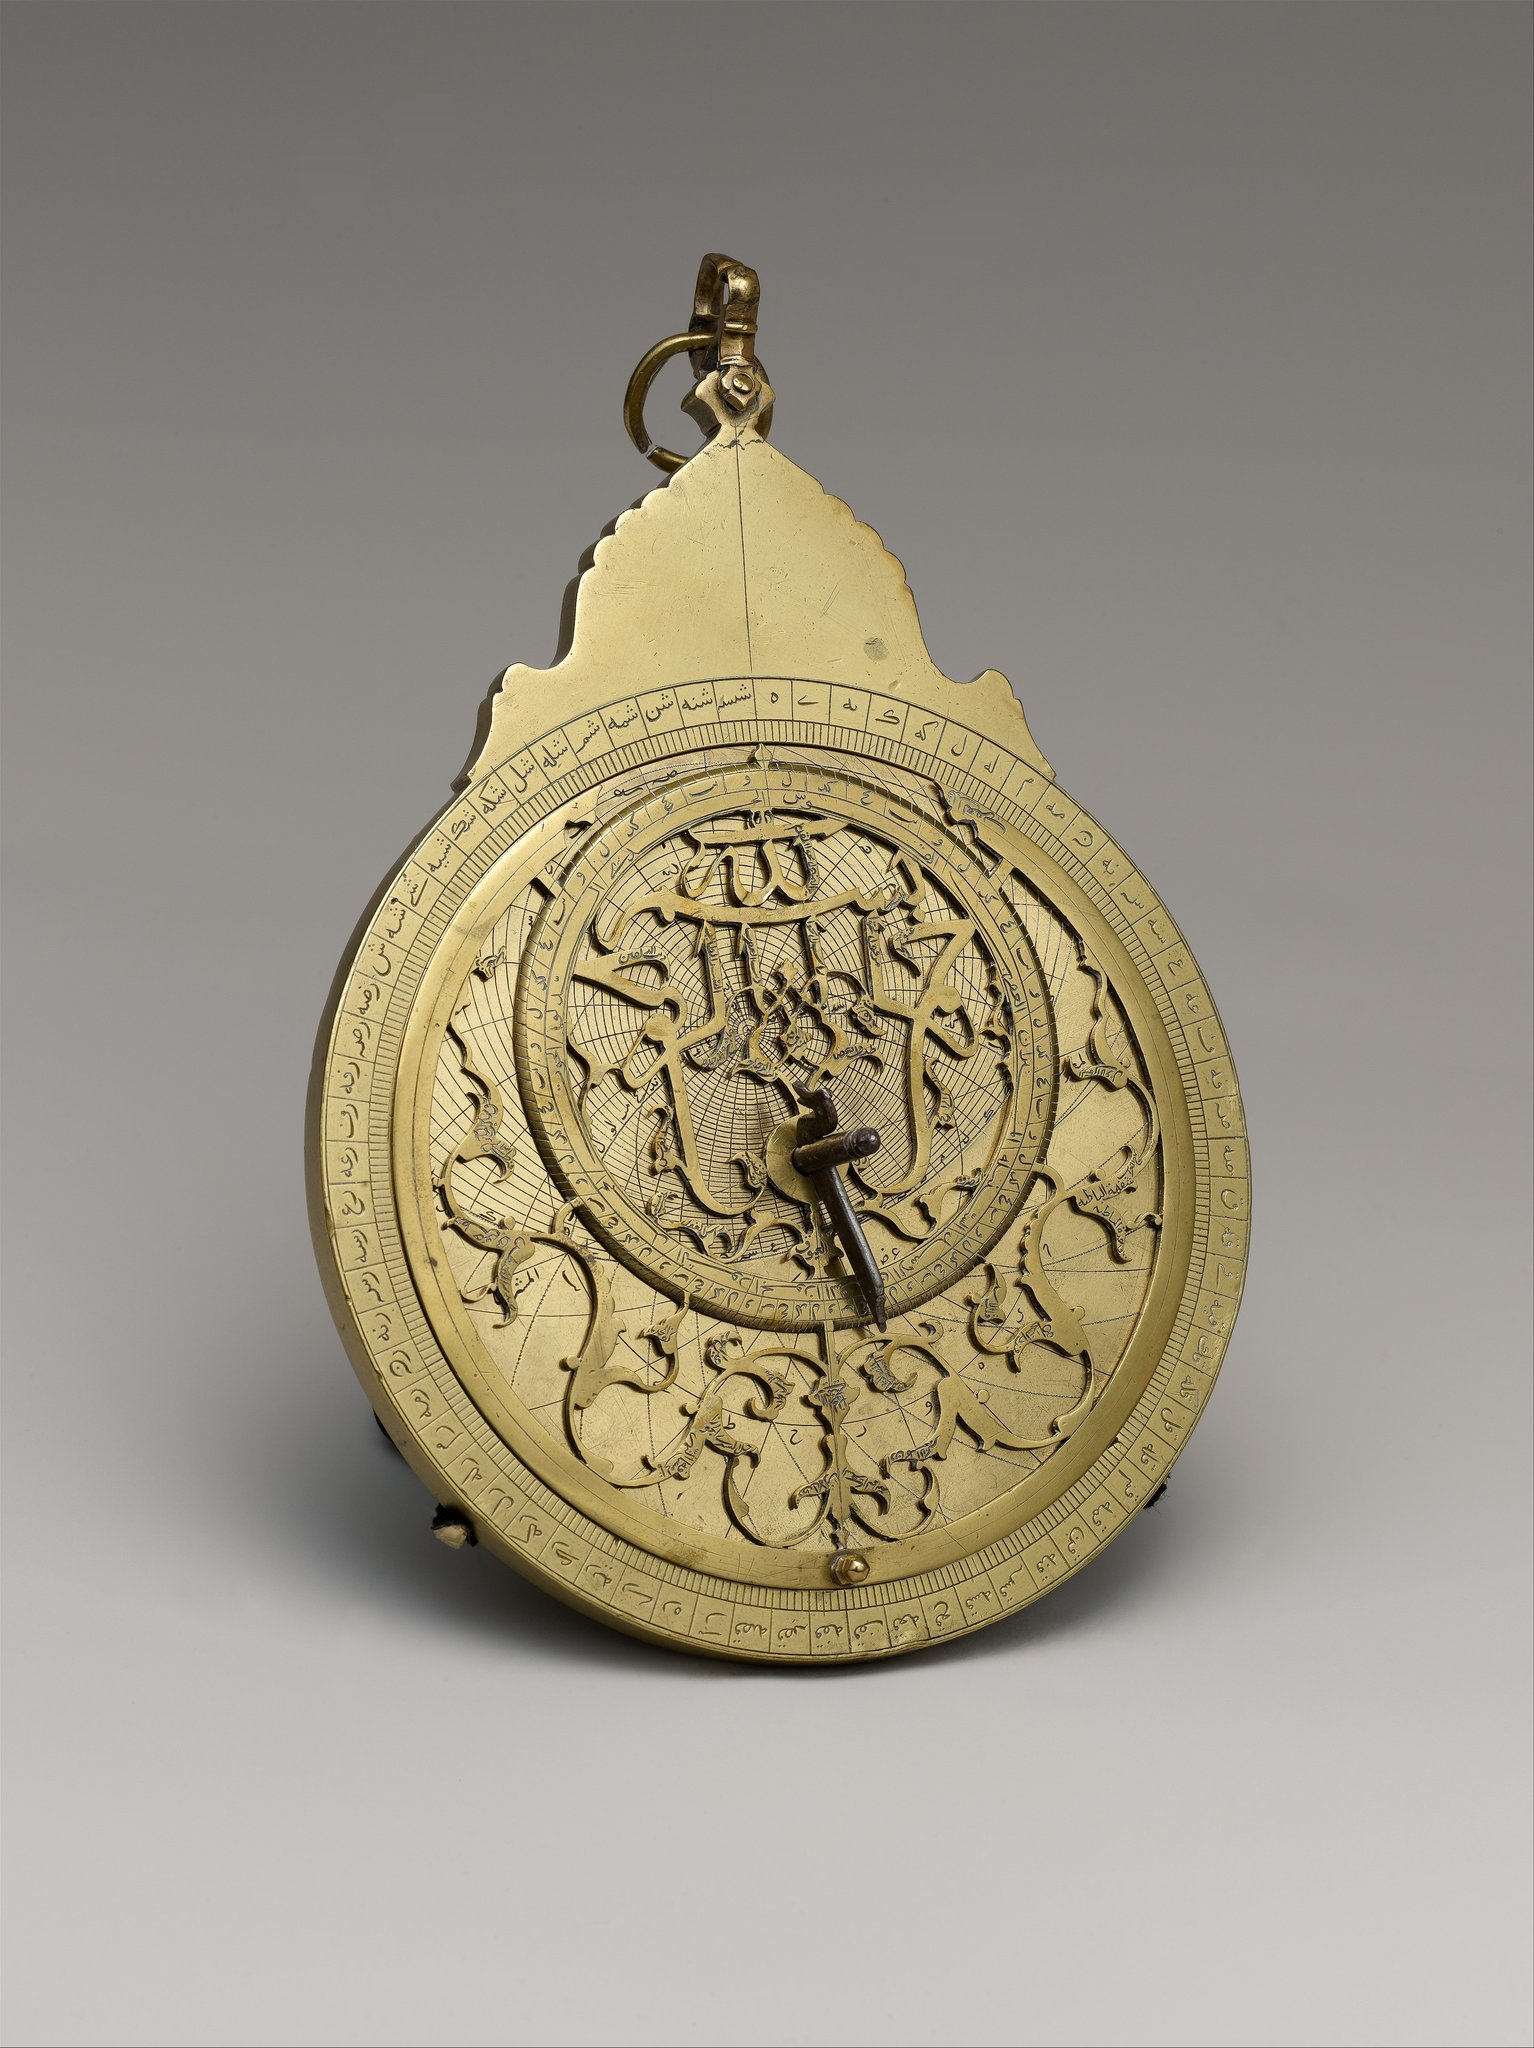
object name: astrolabe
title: Planispheric Astrolabe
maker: muhammad zaman al-munajjim al-asturlabi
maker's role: maker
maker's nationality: iranian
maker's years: 1620-1715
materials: brass, steel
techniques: casting, engraving, hammering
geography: iran